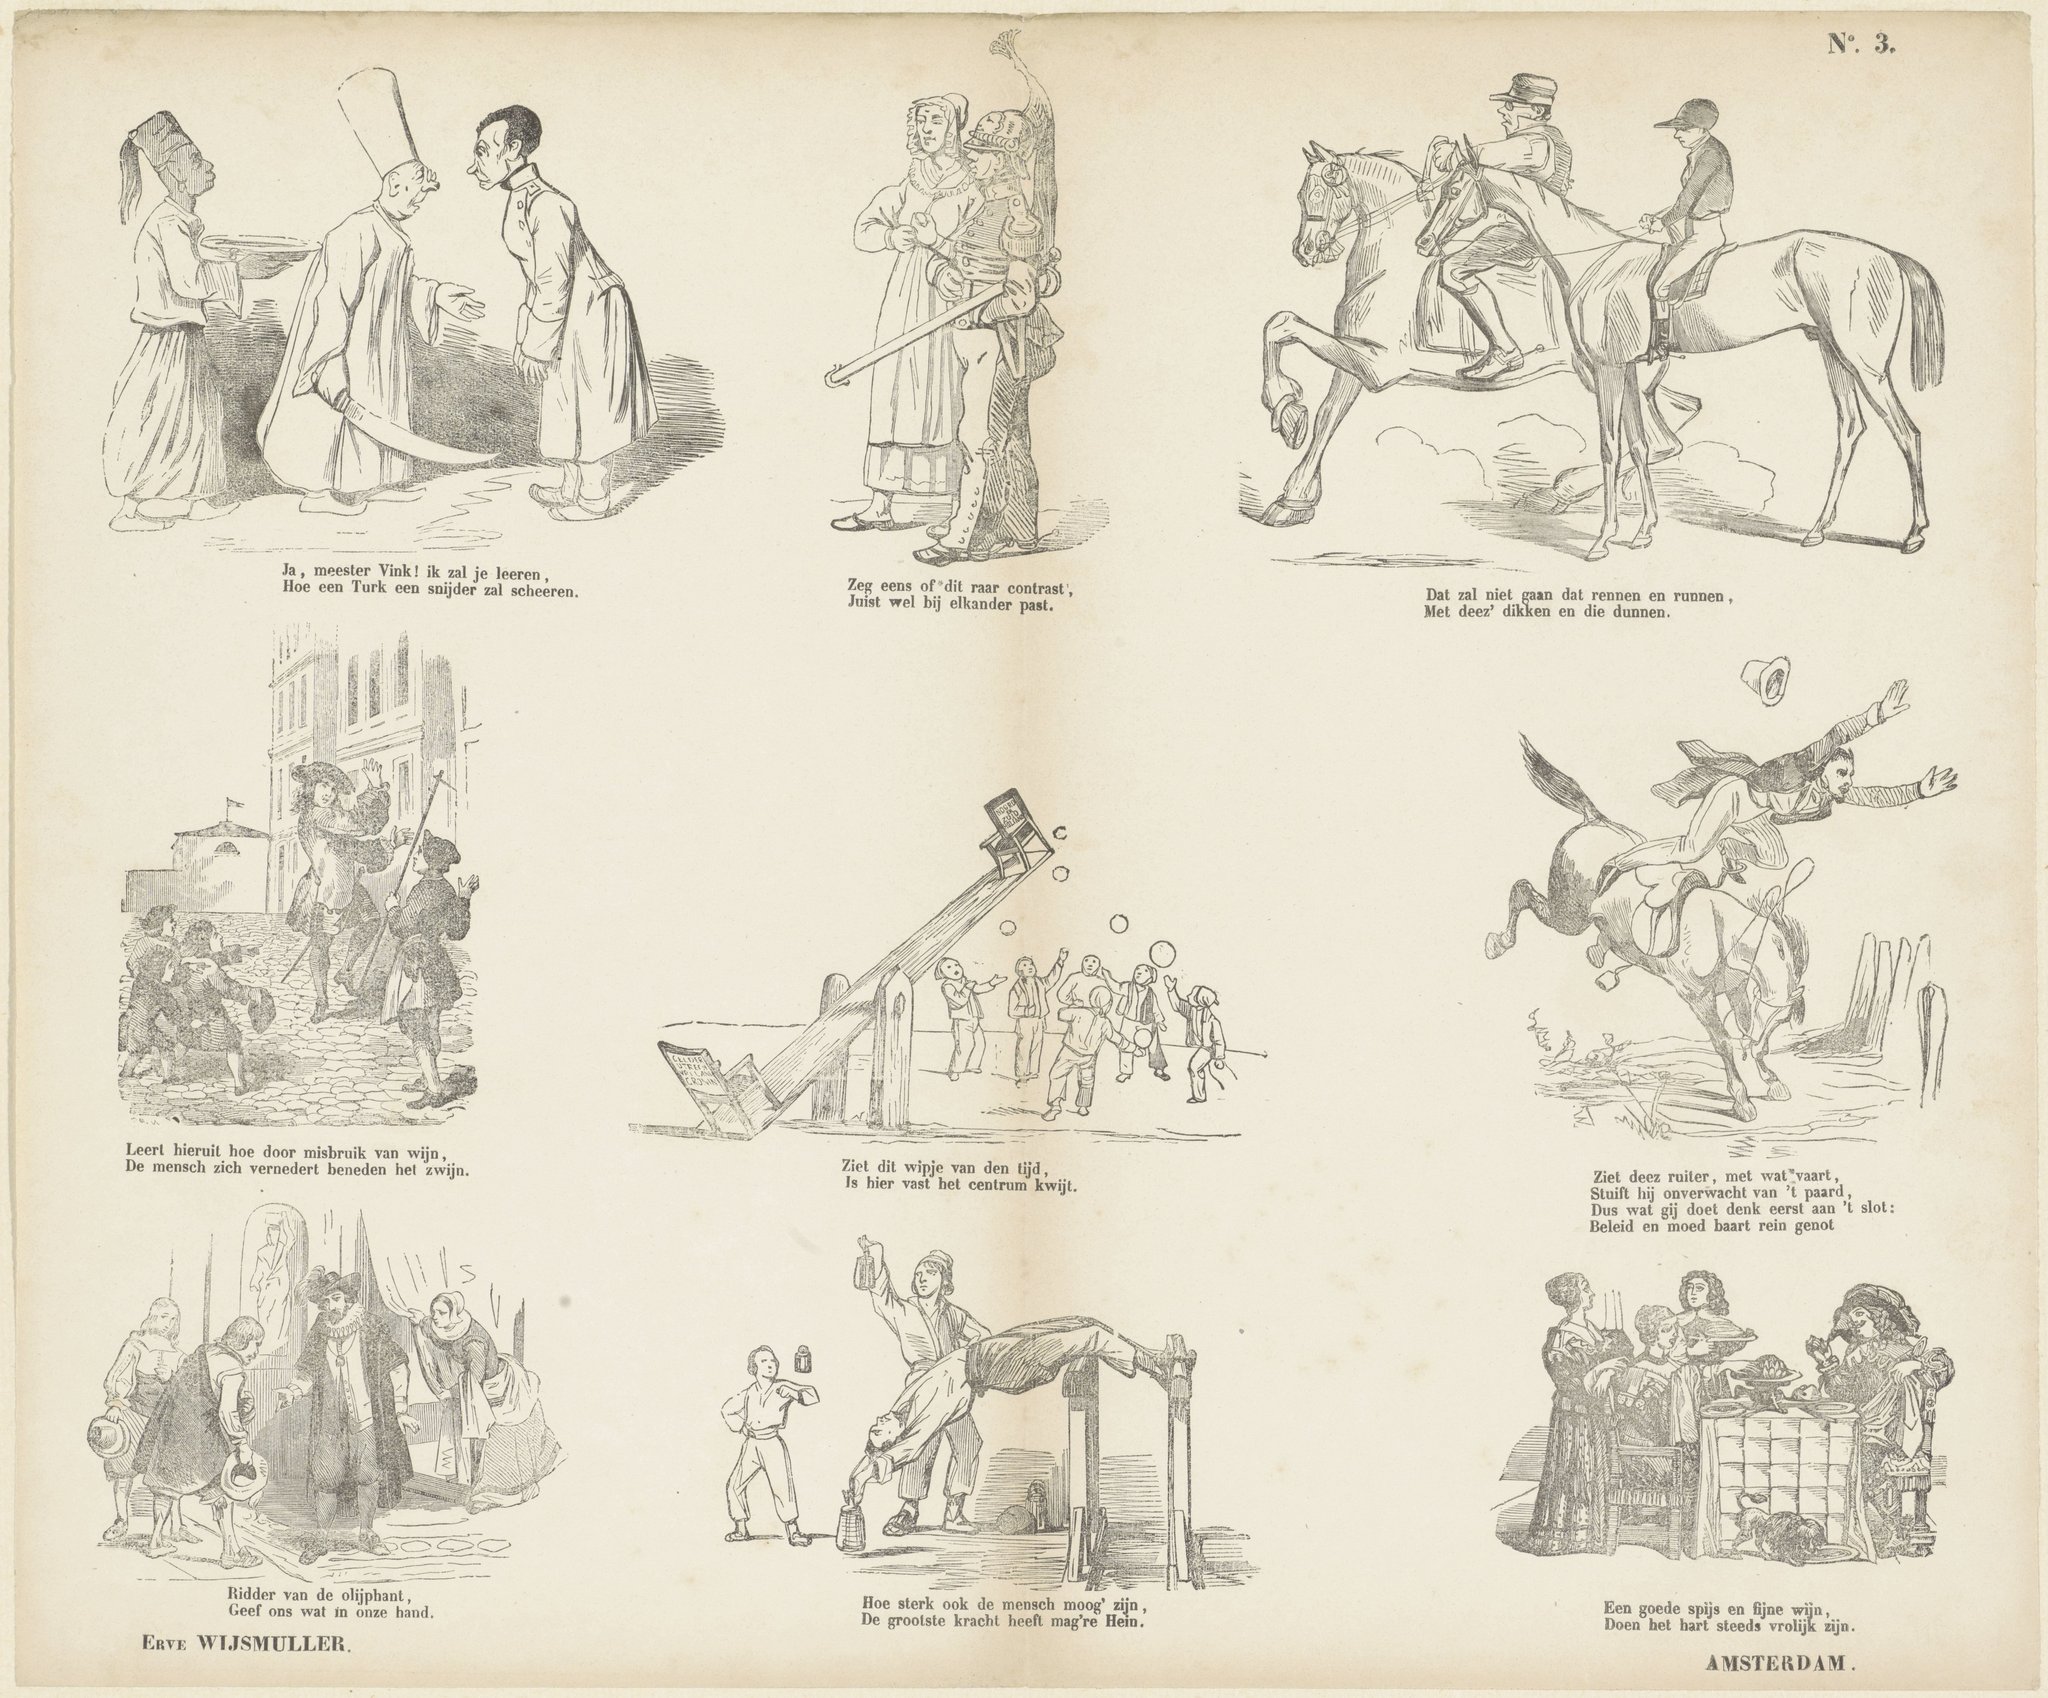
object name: print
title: Verschillende voorstellingen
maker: Anonymous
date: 1828-1913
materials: paper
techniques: letterpress printing, line block, engraving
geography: amsterdam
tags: riding a horse, ass, or mule; rider, horseman, drunkard, drunkenness, the soldier off duty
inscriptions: collector's mark: Lugt 2760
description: Blad met 9 voorstellingen van verschillende aard, waaronder een Turk met zwaard, een vrouw met militair, paarden met ruiters, dronken lieden, een wip en spelende kinderen en een paard dat weigert. Onder elke afbeelding een onderschrift. Onder de eerste afbeelding het onderschrift: Ja, meester Vink! ik zal je leeren… Genummerd rechtsboven: No. 3.